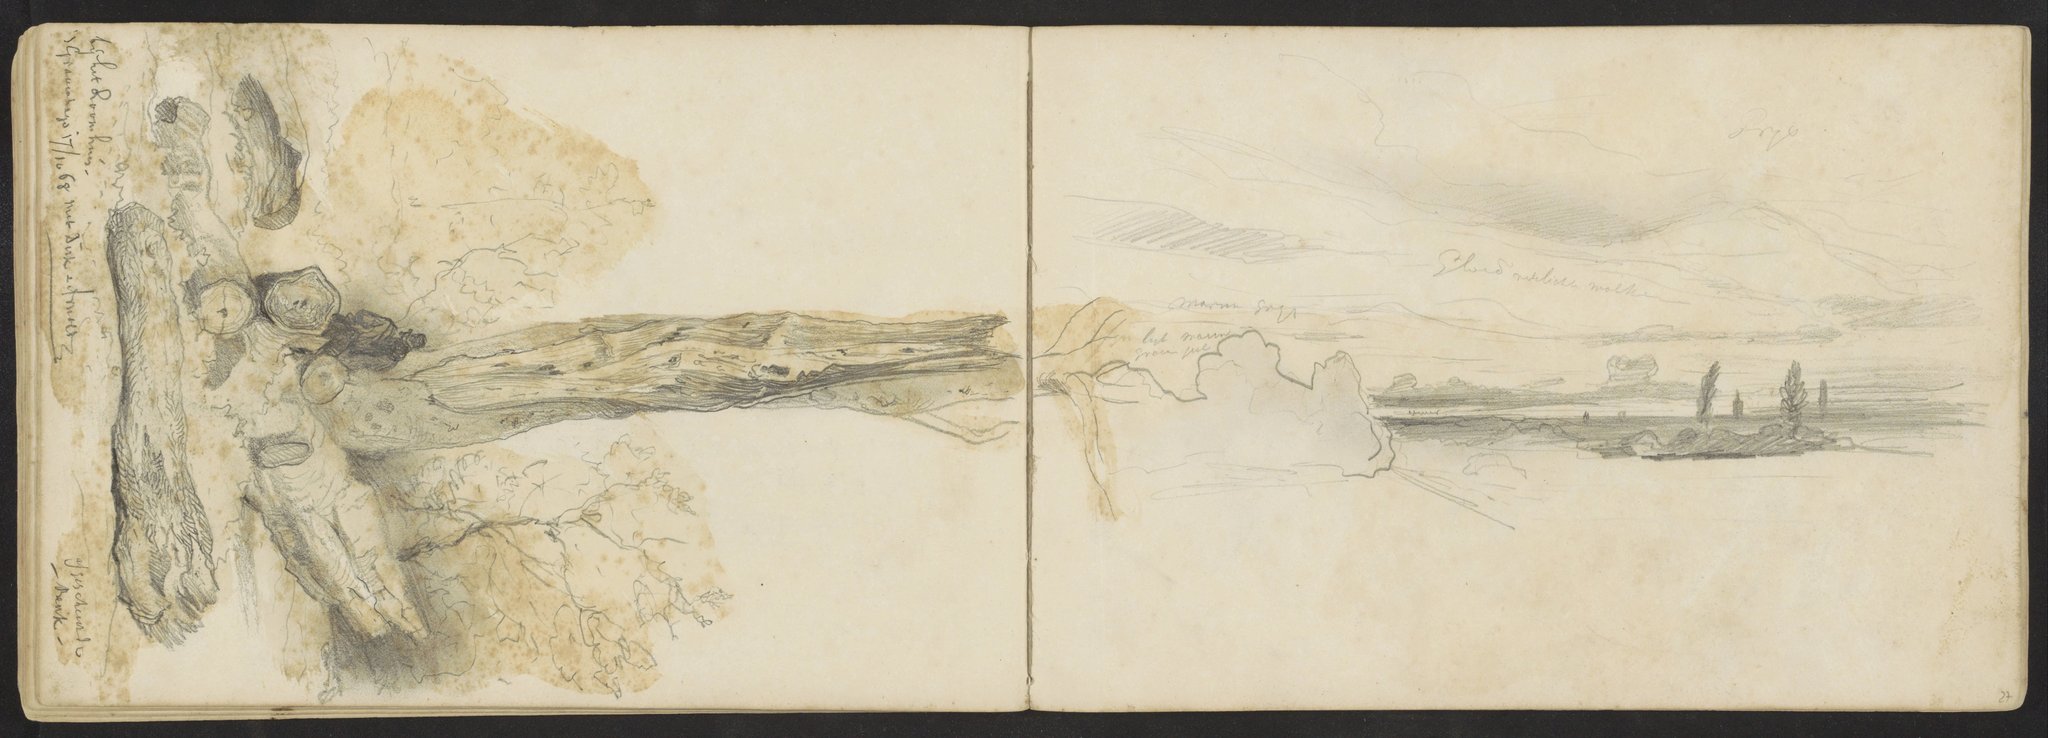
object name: sketchbook leaf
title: Haagse bos met een man bij een in stukken gescheurde beuk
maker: johannes tavenraat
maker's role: draughtsman, painter, print maker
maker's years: 1809-1881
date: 1810-1868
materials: paper, pencil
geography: the hague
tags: forest, wood, trees: beech, the hague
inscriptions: date and inscription: ‘bij het Loomhuis/ 's Gravenhage 17/10 68 met Dirk & [...]/ afgescheurde beuk’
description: Blad 26 verso in een schetsboek met 45 bladen.